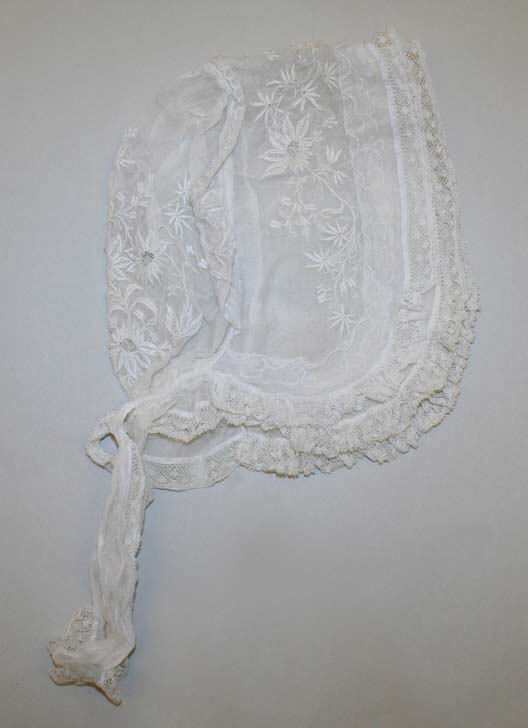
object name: bonnet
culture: american or european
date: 1801-1833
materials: cotton